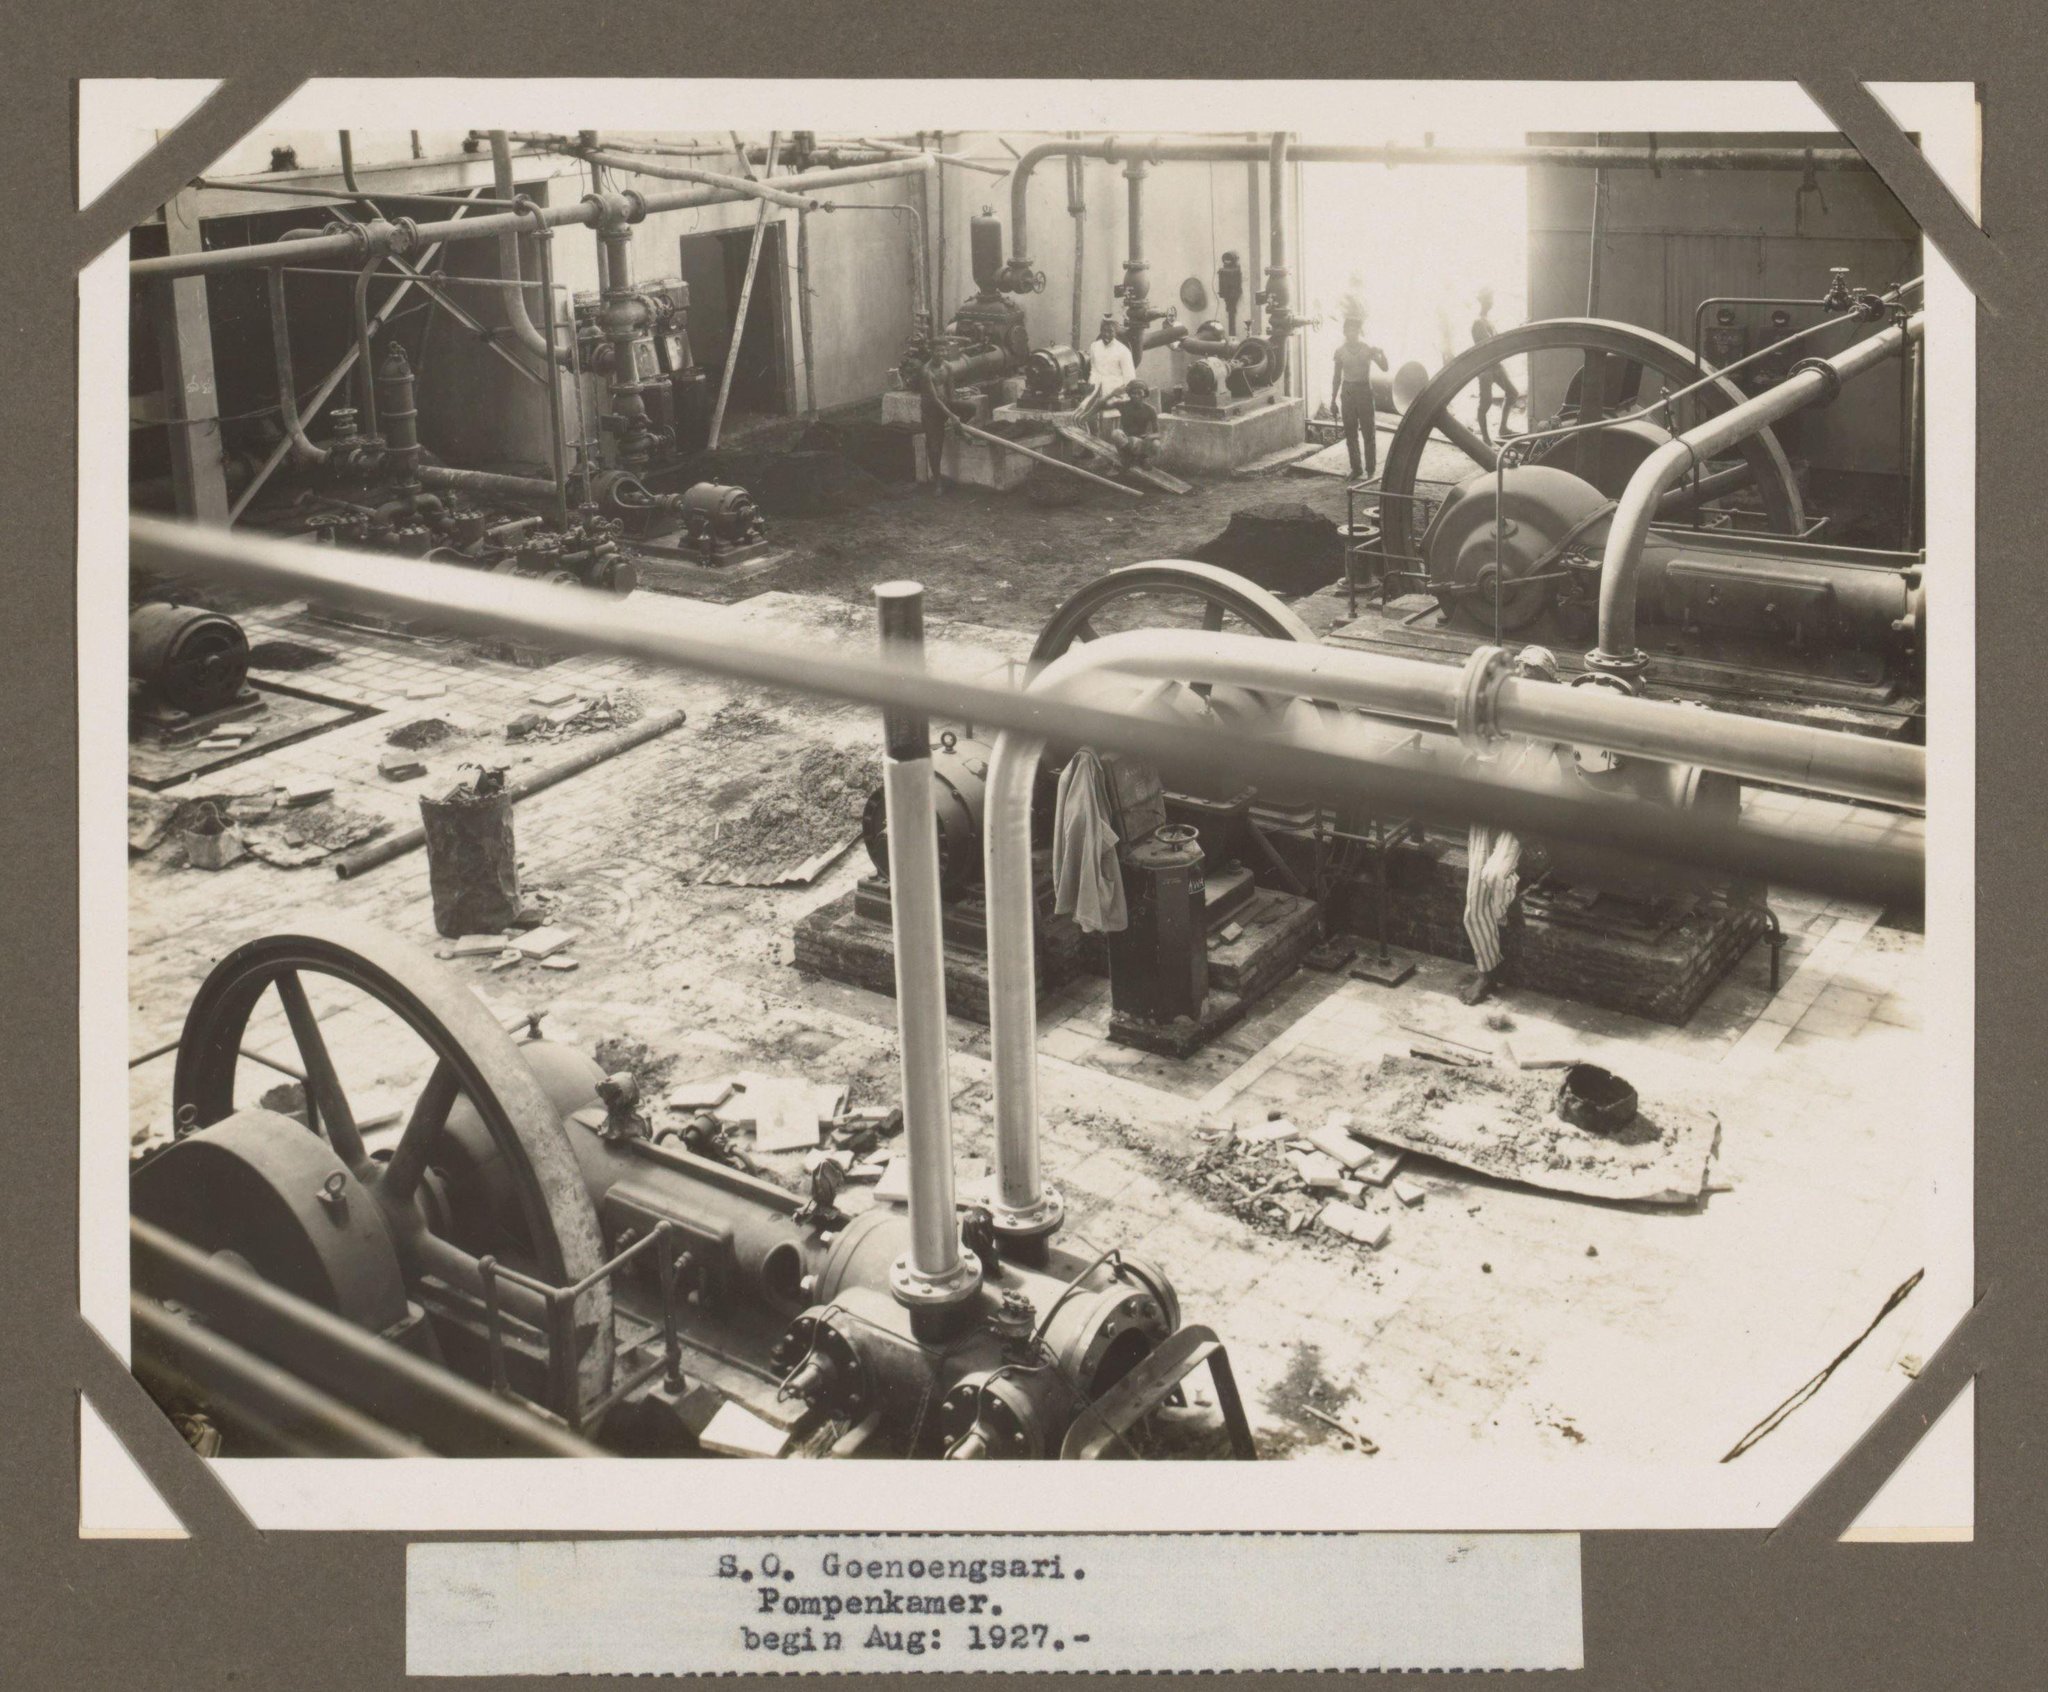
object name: photograph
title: S.O. Goenoengsari. Pompenkamer. begin Aug: 1927.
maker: Anonymous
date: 1908-1927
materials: photographic support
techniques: gelatin silver print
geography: east java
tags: colonial system, trade-company, factory-interior, machine shop, making the overground structures (~ building activities), (non-fruit) products of plants or trees: sugarcane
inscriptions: inscription: ‘S.O. Goenoengsari. Pompenkamer. begin Aug: 1927.’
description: Fabriekshal met installatie van pompen, augustus 1927. Met Javaanse arbeiders. Onderdeel van het fotoalbum met foto's van de opbouw van de suikerfabriek te Goenoengsari op Oost-Java door de Handels Vereniging Amsterdam 1926-1927.